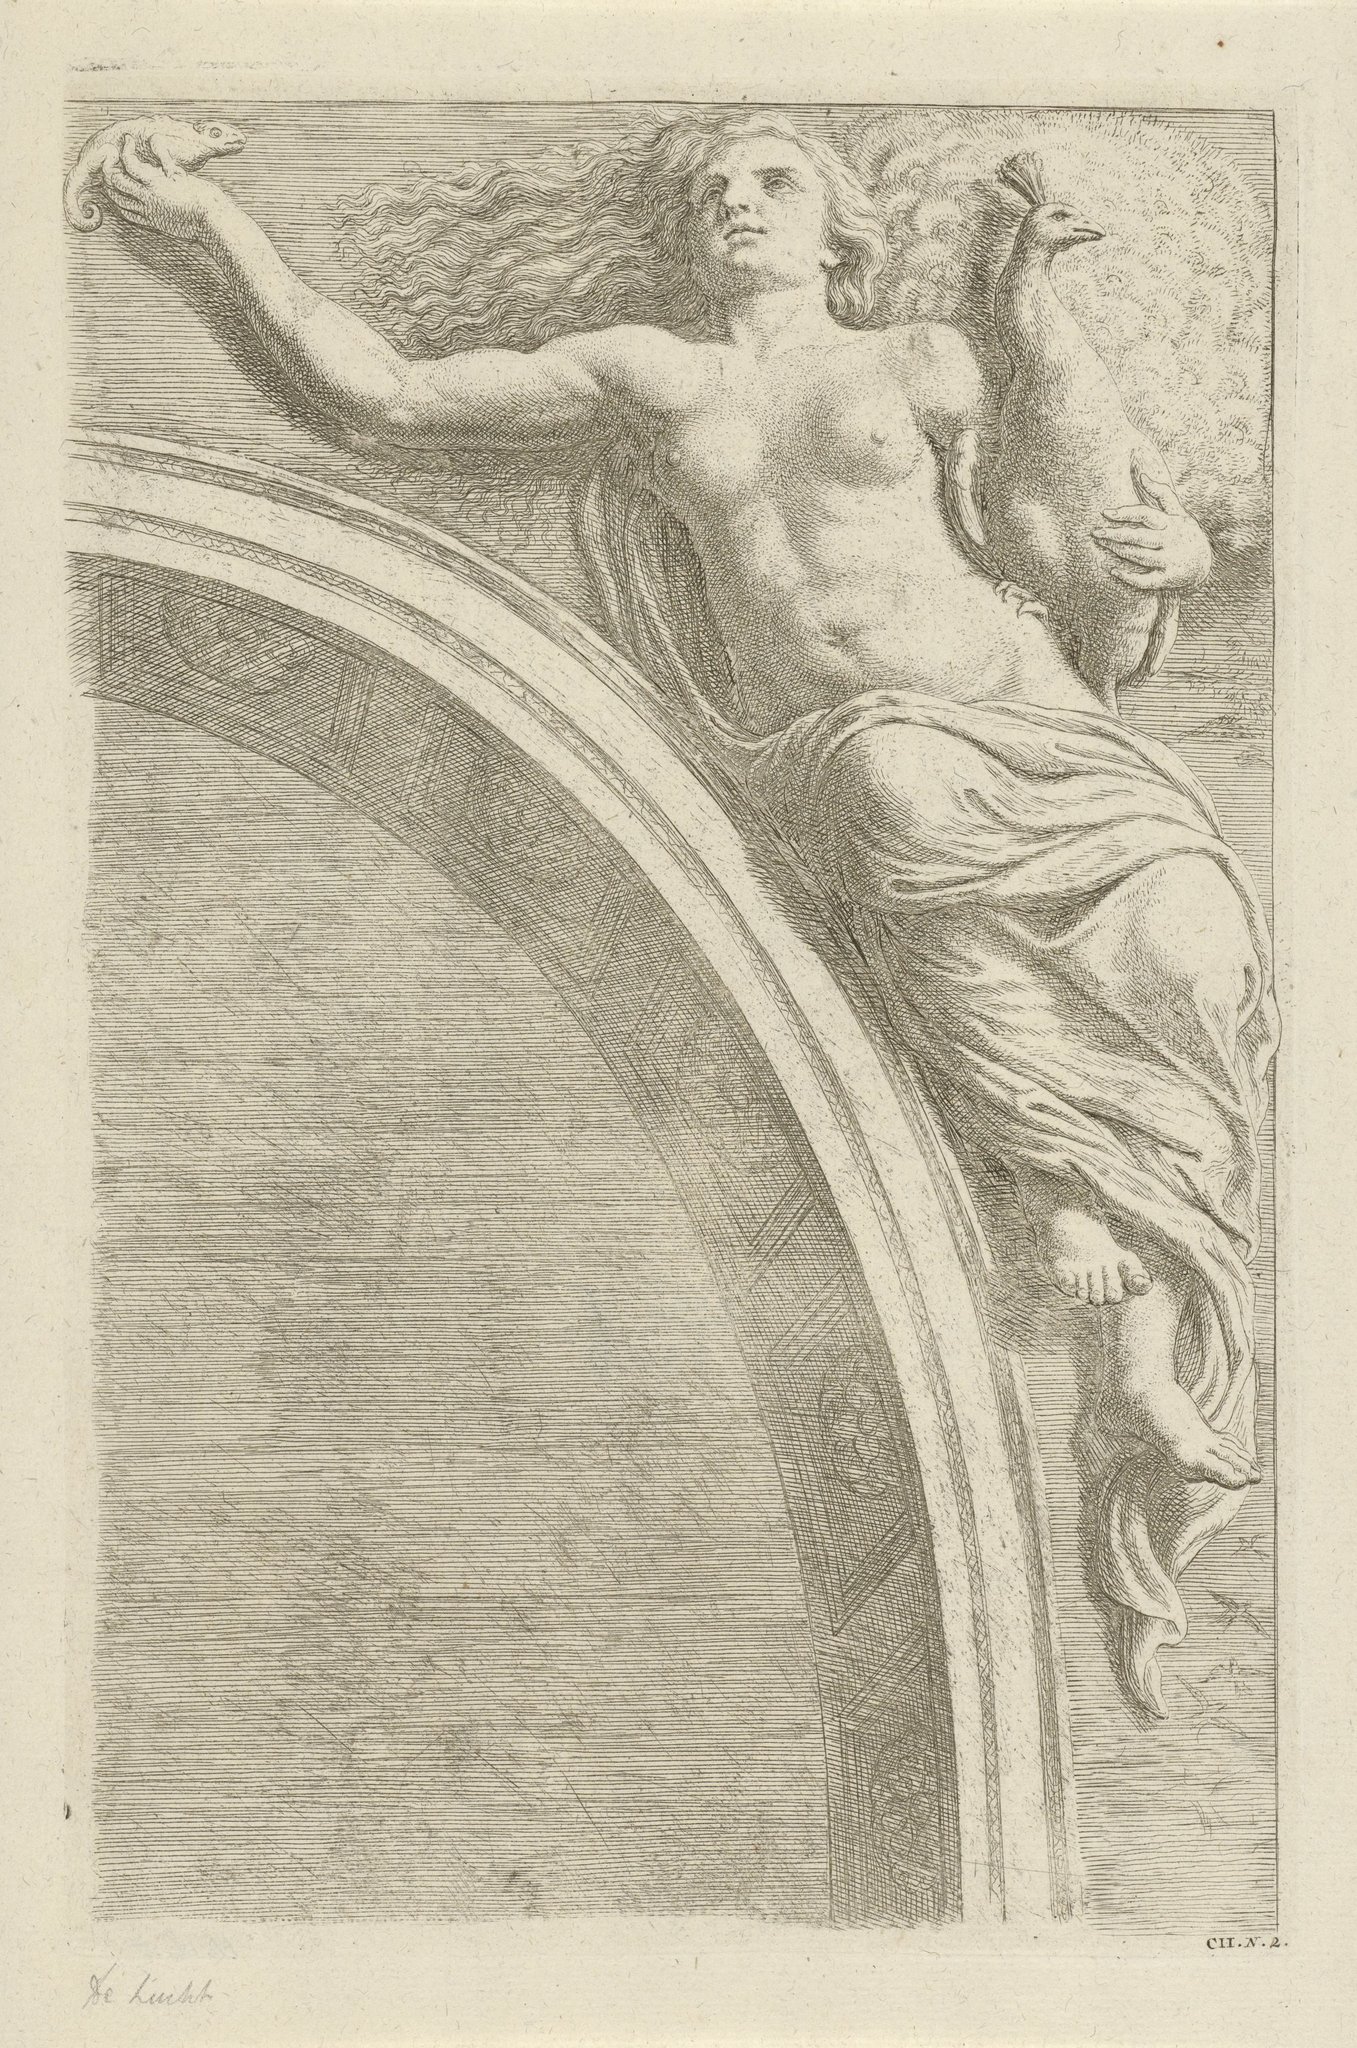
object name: book illustration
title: Reliëf met personificatie van het element Lucht boven boog aan westzijde van de Burgerzaal in het Stadhuis op de Dam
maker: hubert quellinus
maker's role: print maker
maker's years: 1619-1687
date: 1663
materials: paper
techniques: engraving, etching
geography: amsterdam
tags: air (one of the four elements), ornamental birds: peacock, lizards: chameleon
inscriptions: collector's mark: Lugt 2228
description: Huidige staat van prent ook gebruikt in: Architecture peinture et sculpture de la Maison de Ville d'Amsterdam, representee en CIX. figures en taille-douce (…). Amsterdam: David Mortier, 1719. En in: Architecture peinture et sculpture de la Maison de Ville d'Amsterdam, representee en CIX. figures en taille-douce (…). Amsterdam: Gerard Valck, 1719. En in: Bouw schilder en beeldhouwkonst, van het Stadhuis te Amsteldam, vertoont in CIX figuuren (…). Amsterdam: Covens & Mortier & Covens Jr., s.a. (1774-1783). Eerdere staat van prent ook gebruikt in: Secunca pars Praecipuarum effigierum ac ornamentorum amplissime Curiae Amstelrodamensis maiori ex parte in cadido marmore effectorum per Artum Quellinium eiusdem Civitatis Statuarium / Het tweede deel Van de voornaemste Statuen ende Cieraten van 't konst-rijcke Stadt-huys van Amstelredam 'tmeeste in Marmer gemaeckt door Artus Quellinus Beelthouwer der voorseyde Stadt. Amsterdam: Artus Quellinus (I), 1663. En in: Secunca pars Praecipuarum effigierum ac ornamentorum amplissime Curiae Amstelrodamensis maiori ex parte in cadido marmore effectorum per Artum Quellinium eiusdem Civitatis Statuarium / Het tweede deel Van de voornaemste Statuen ende Cieraten van 't konst-rijcke Stadt-huys van Amstelredam 'tmeeste in Marmer gemaeckt door Artus Quellinus Beelthouwer der voorseyde Stadt. Amsterdam: Frederik de Wit, 1668.